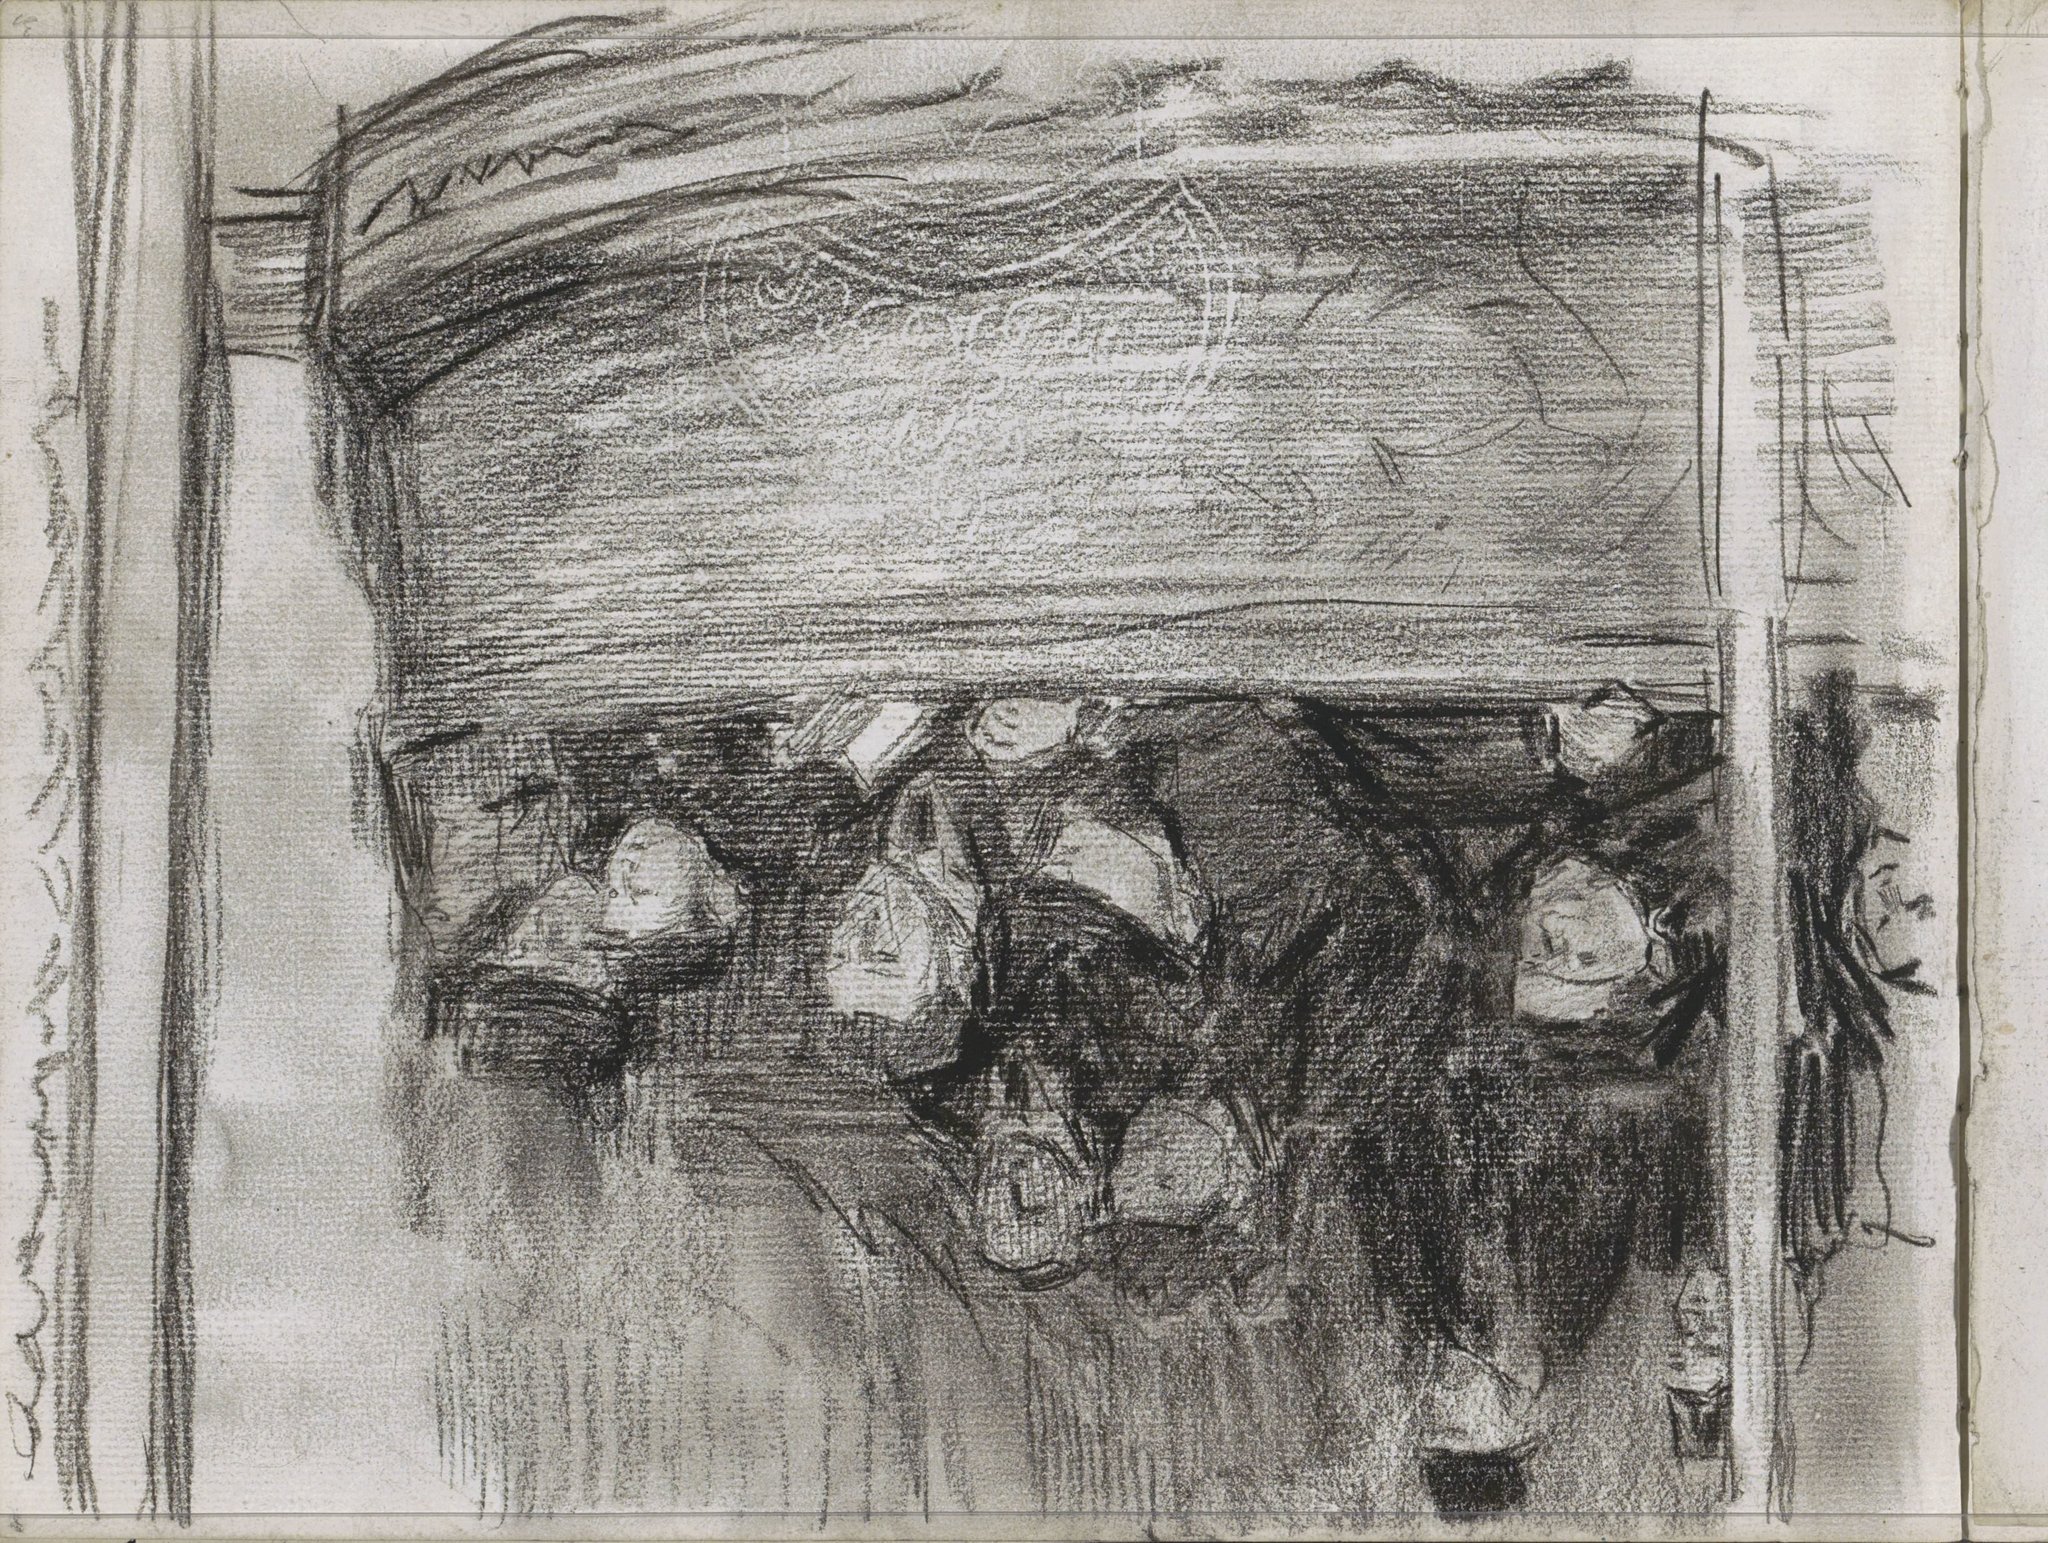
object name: sketchbook leaf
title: Toeschouwers op een balkon, mogelijk in een loge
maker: isaac israels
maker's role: draughtsman, painter, print maker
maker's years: 1865-1934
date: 1875-1934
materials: chalk, paper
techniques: stumping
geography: the hague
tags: boxes, loges ~ theatre, etc., the audience ~ art performance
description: Blad 4 verso uit schetsboek XIV met 17 bladen.